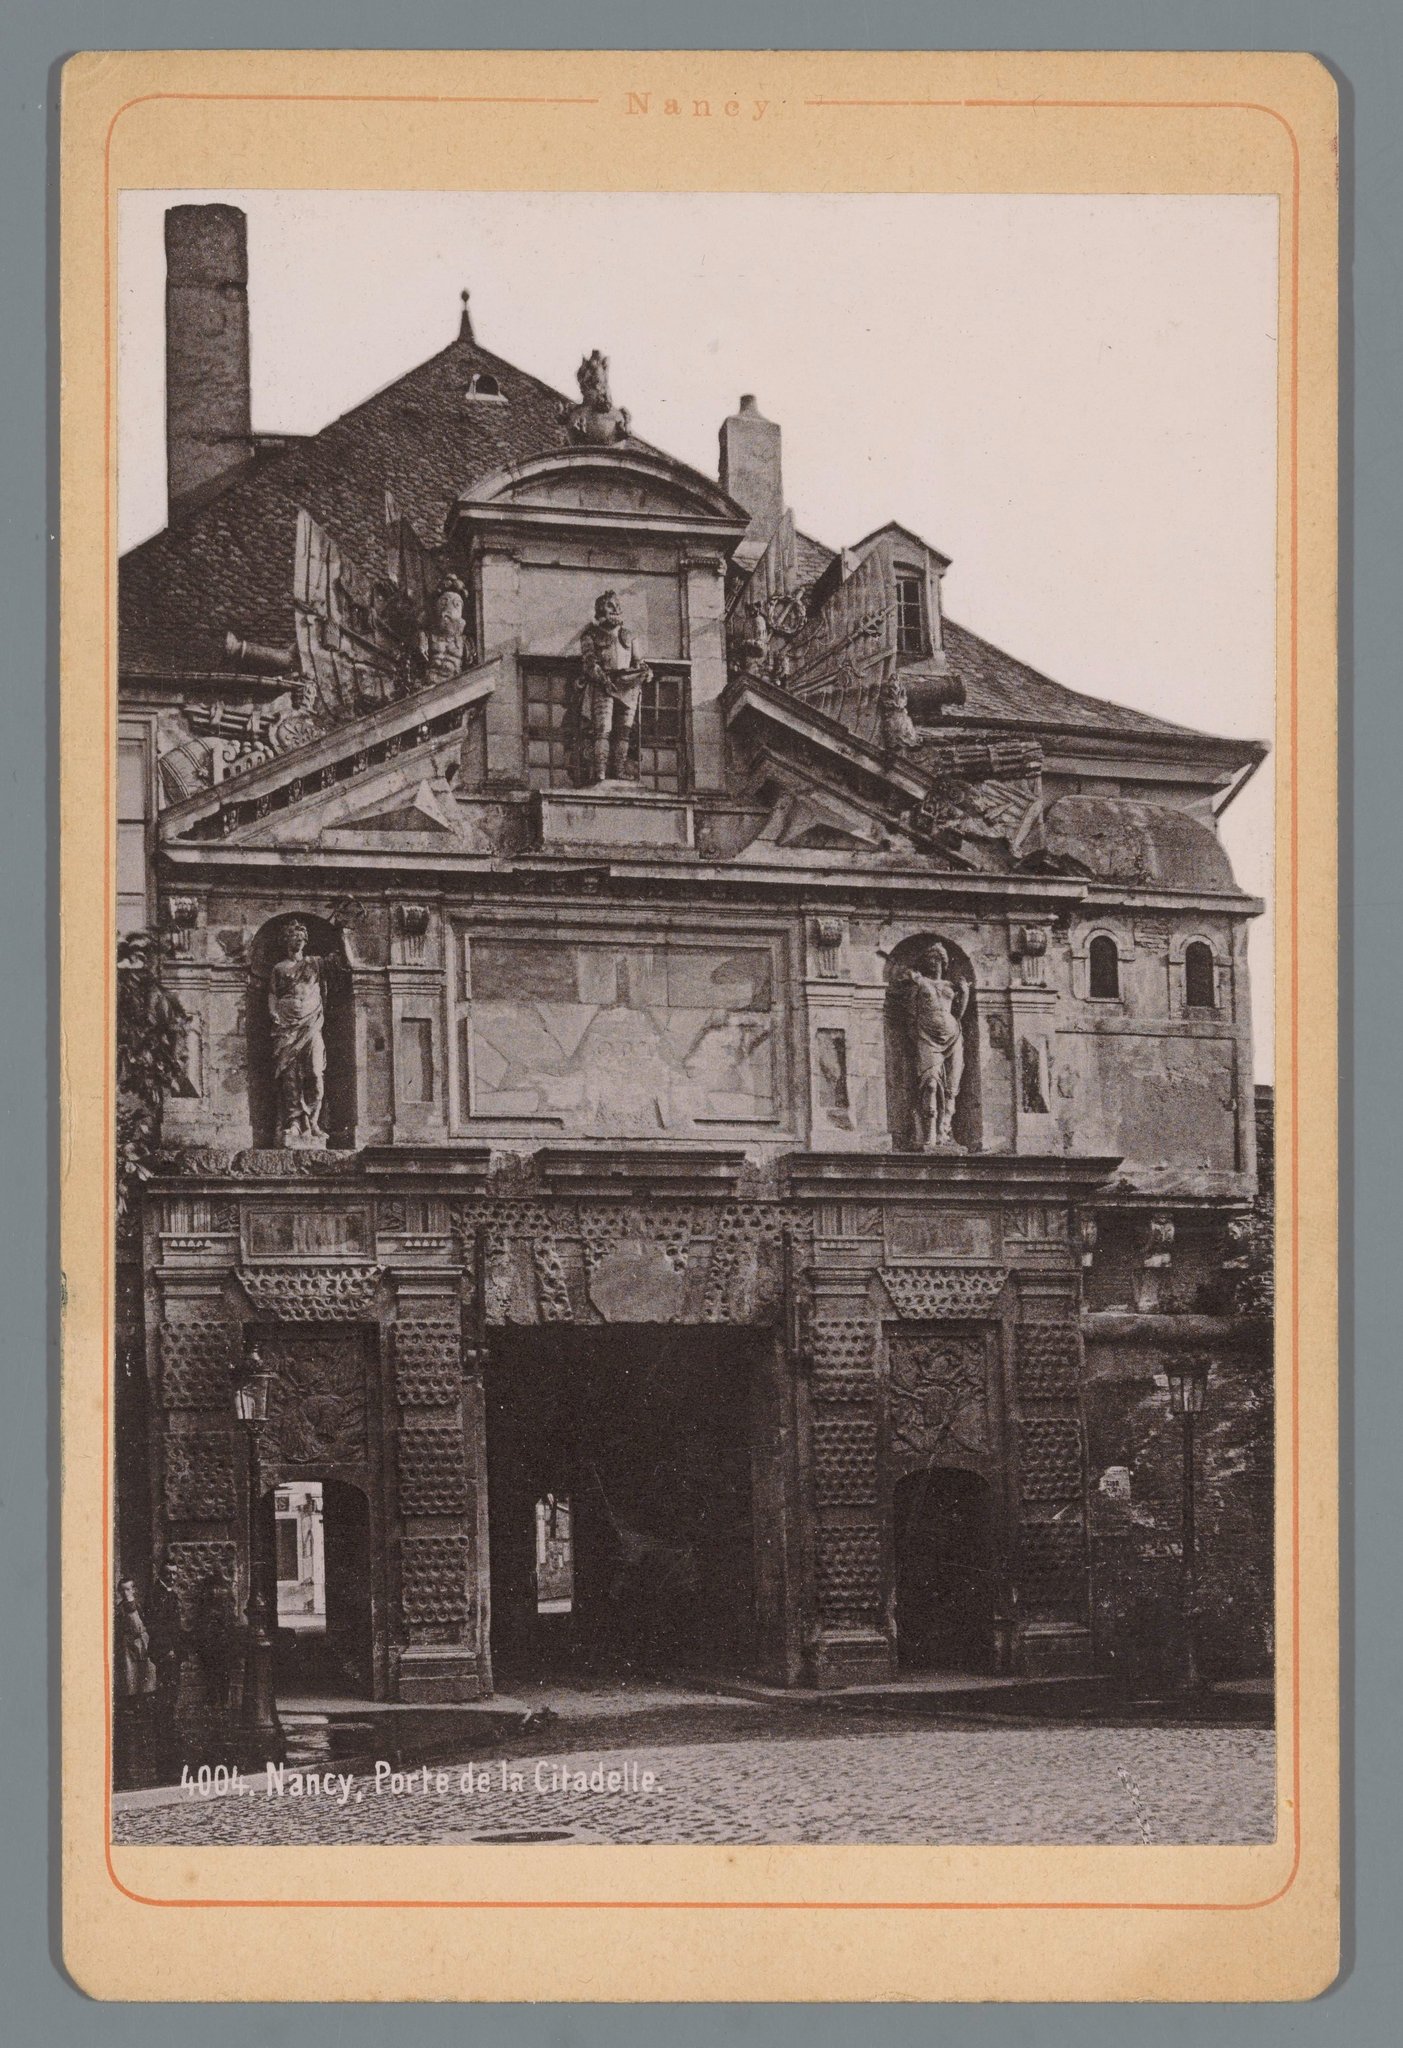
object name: cabinet photograph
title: Gezicht op de Porte de la Citadelle te Nancy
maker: Anonymous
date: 1875-1930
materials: cardboard, paper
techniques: photograph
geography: nancy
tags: parts of church exterior and annexes, façade (of house or building)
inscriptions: number: ‘4004.’